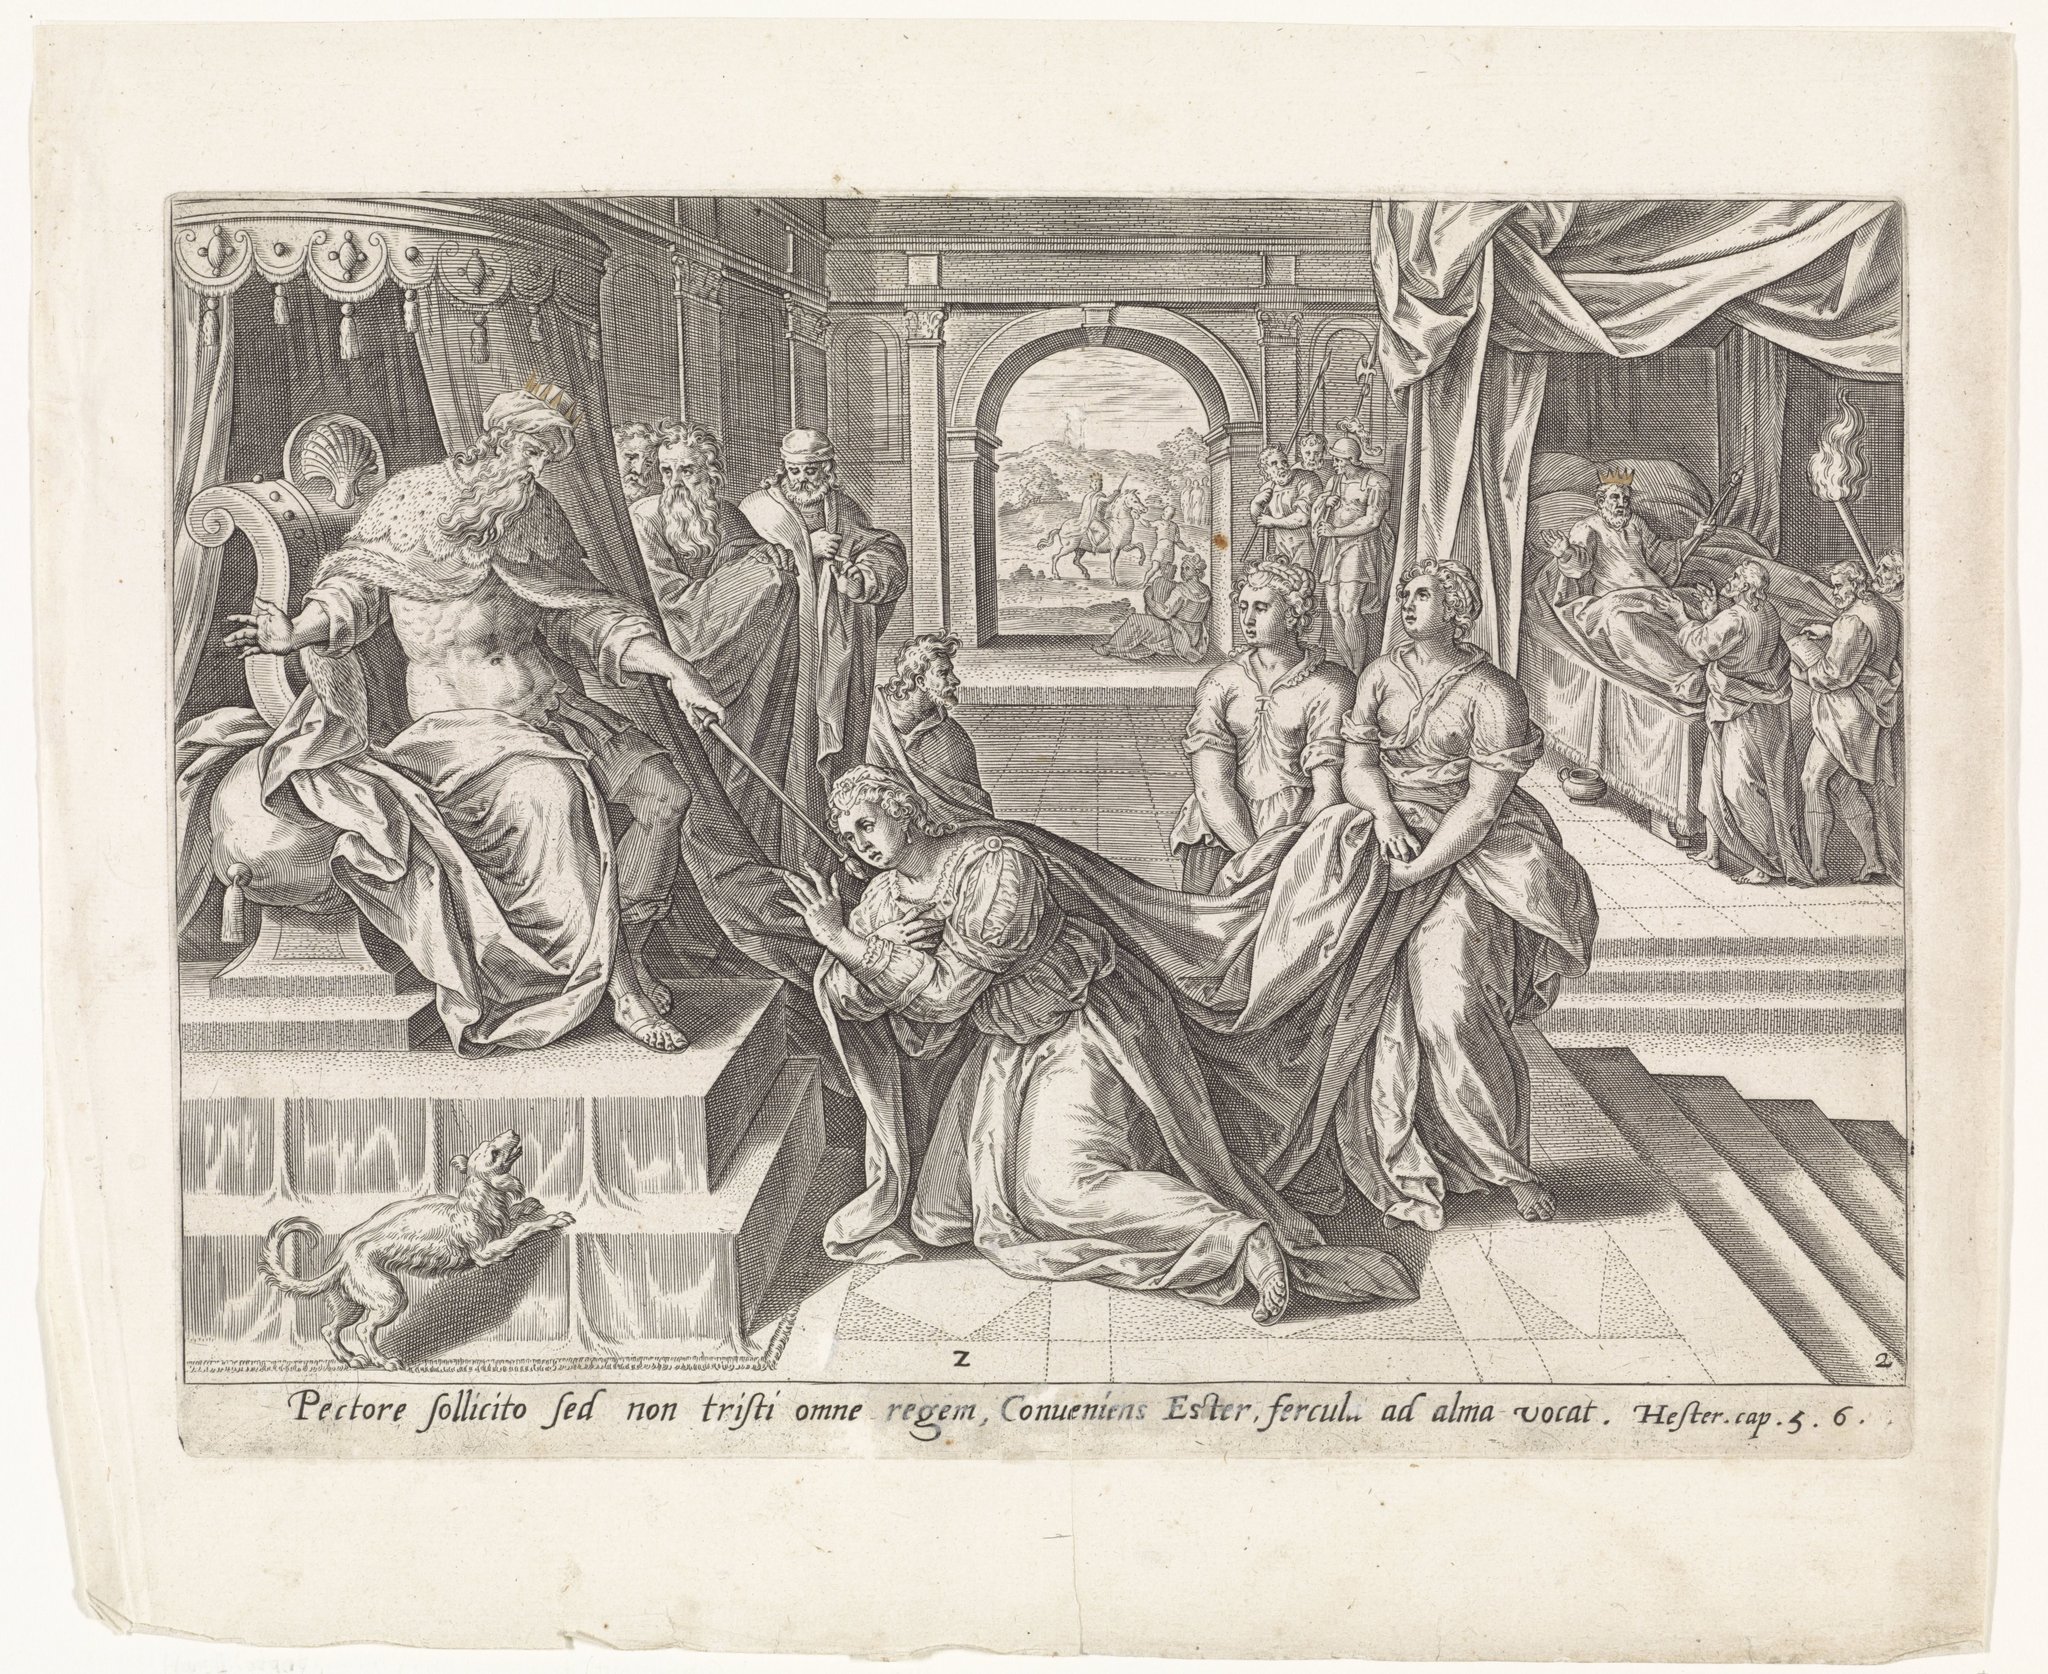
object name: print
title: Ester voor Ahasveros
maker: hans collaert (i)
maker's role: draughtsman, print maker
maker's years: 1520-1581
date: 1579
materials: paper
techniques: engraving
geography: antwerp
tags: mordecai's triumph: mordecai, mounted on the king's horse, is led through the city by haman (esther and ahasuerus may be looking on from the palace), ahasuerus holds out his sceptre to esther (esther usually kneeling), ahasuerus being sleepless, has the court records read to him, king ahasuerus asks haman how to honour a man he wishes to reward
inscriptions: collector's mark: Lugt 2228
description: Ester knielt voor koning Ahasveros. De koning wijst zijn scepter naar haar als teken van genegenheid. Ester verzoekt de koning om samen met Haman naar het door haar verzorgde feestmaal te komen. Rechts op de achtergrond het vervolg van het verhaal. De koning laat zich 's avonds voorlezen uit de kronieken van het rijk. Daarin staat dat Mordechai een aanslag op het leven van de koning heeft verijdeld. De koning vraagt aan Haman, die bij het bed staat, hoe iemand die het leven van de koning heeft gered geëerd moet worden. Op de achtergrond is te zien hoe Mordechai in het kleed van en op het paard van de koning wordt rondgereden, terwijl Haman hem rondleidt. Onder de voorstelling een verwijzing in het Latijn naar de Bijbeltekst in Est. 5-6.